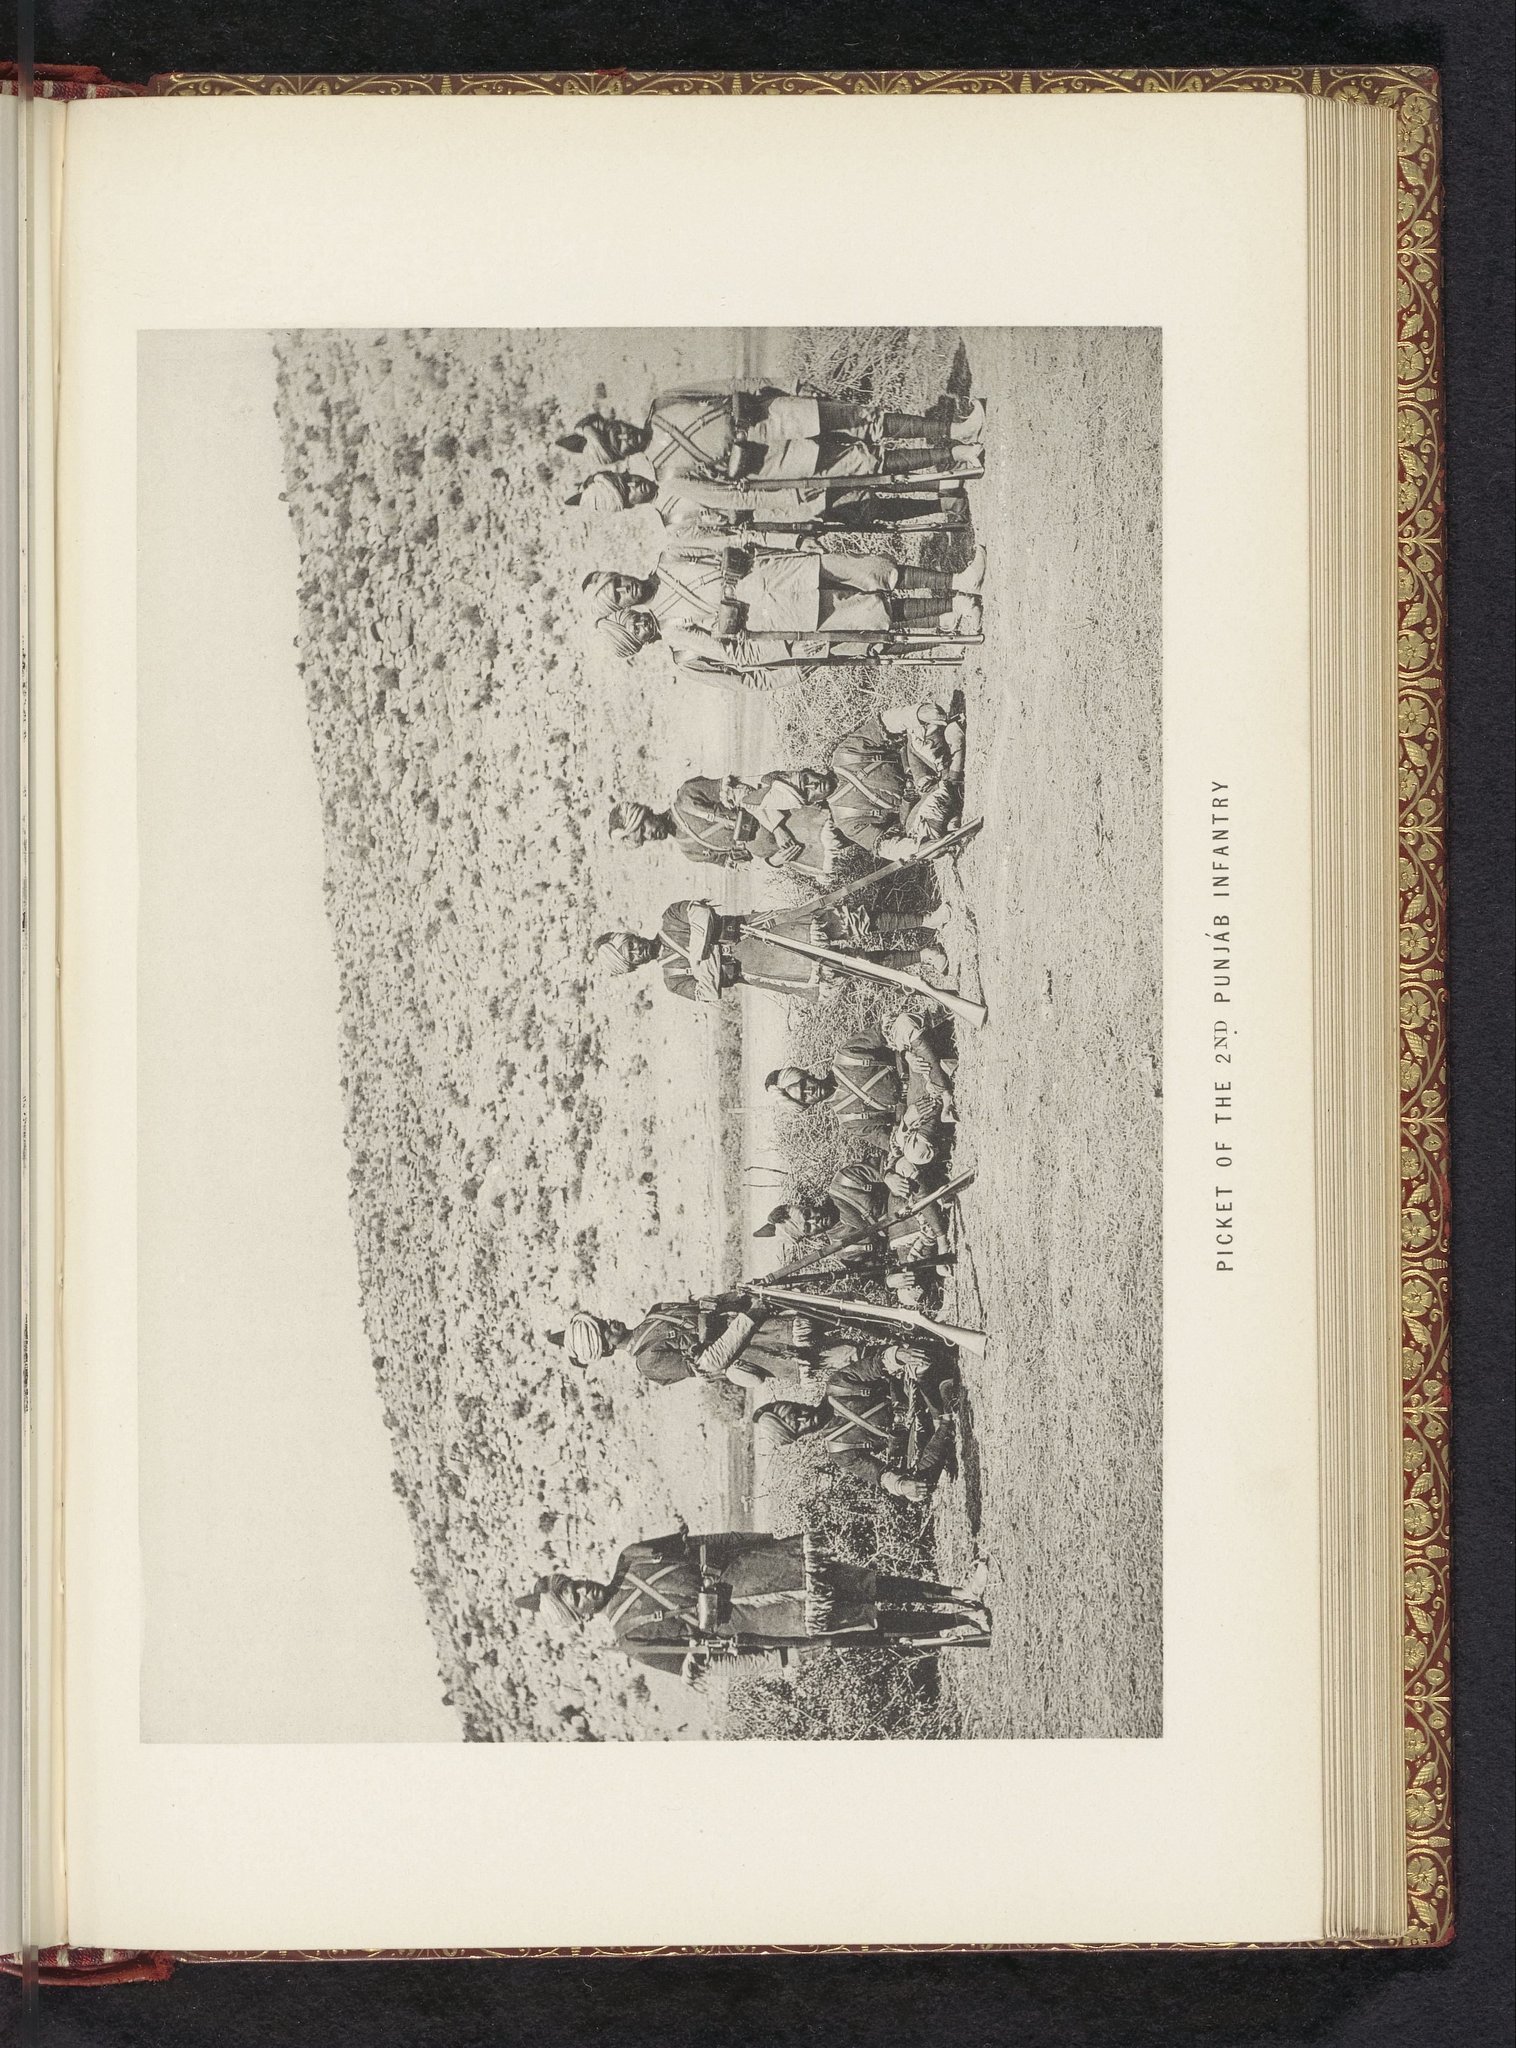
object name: page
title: Infantrymen of the 2nd Punjab Army at Biland Khel, Khyber Pakhtunkhwa, Pakistan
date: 1890-1895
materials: paper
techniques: photograph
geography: biland khel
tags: private soldier (+ infantry)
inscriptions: caption: ‘PICKET OF THE 2ND PUNJÁB INFANTRY’